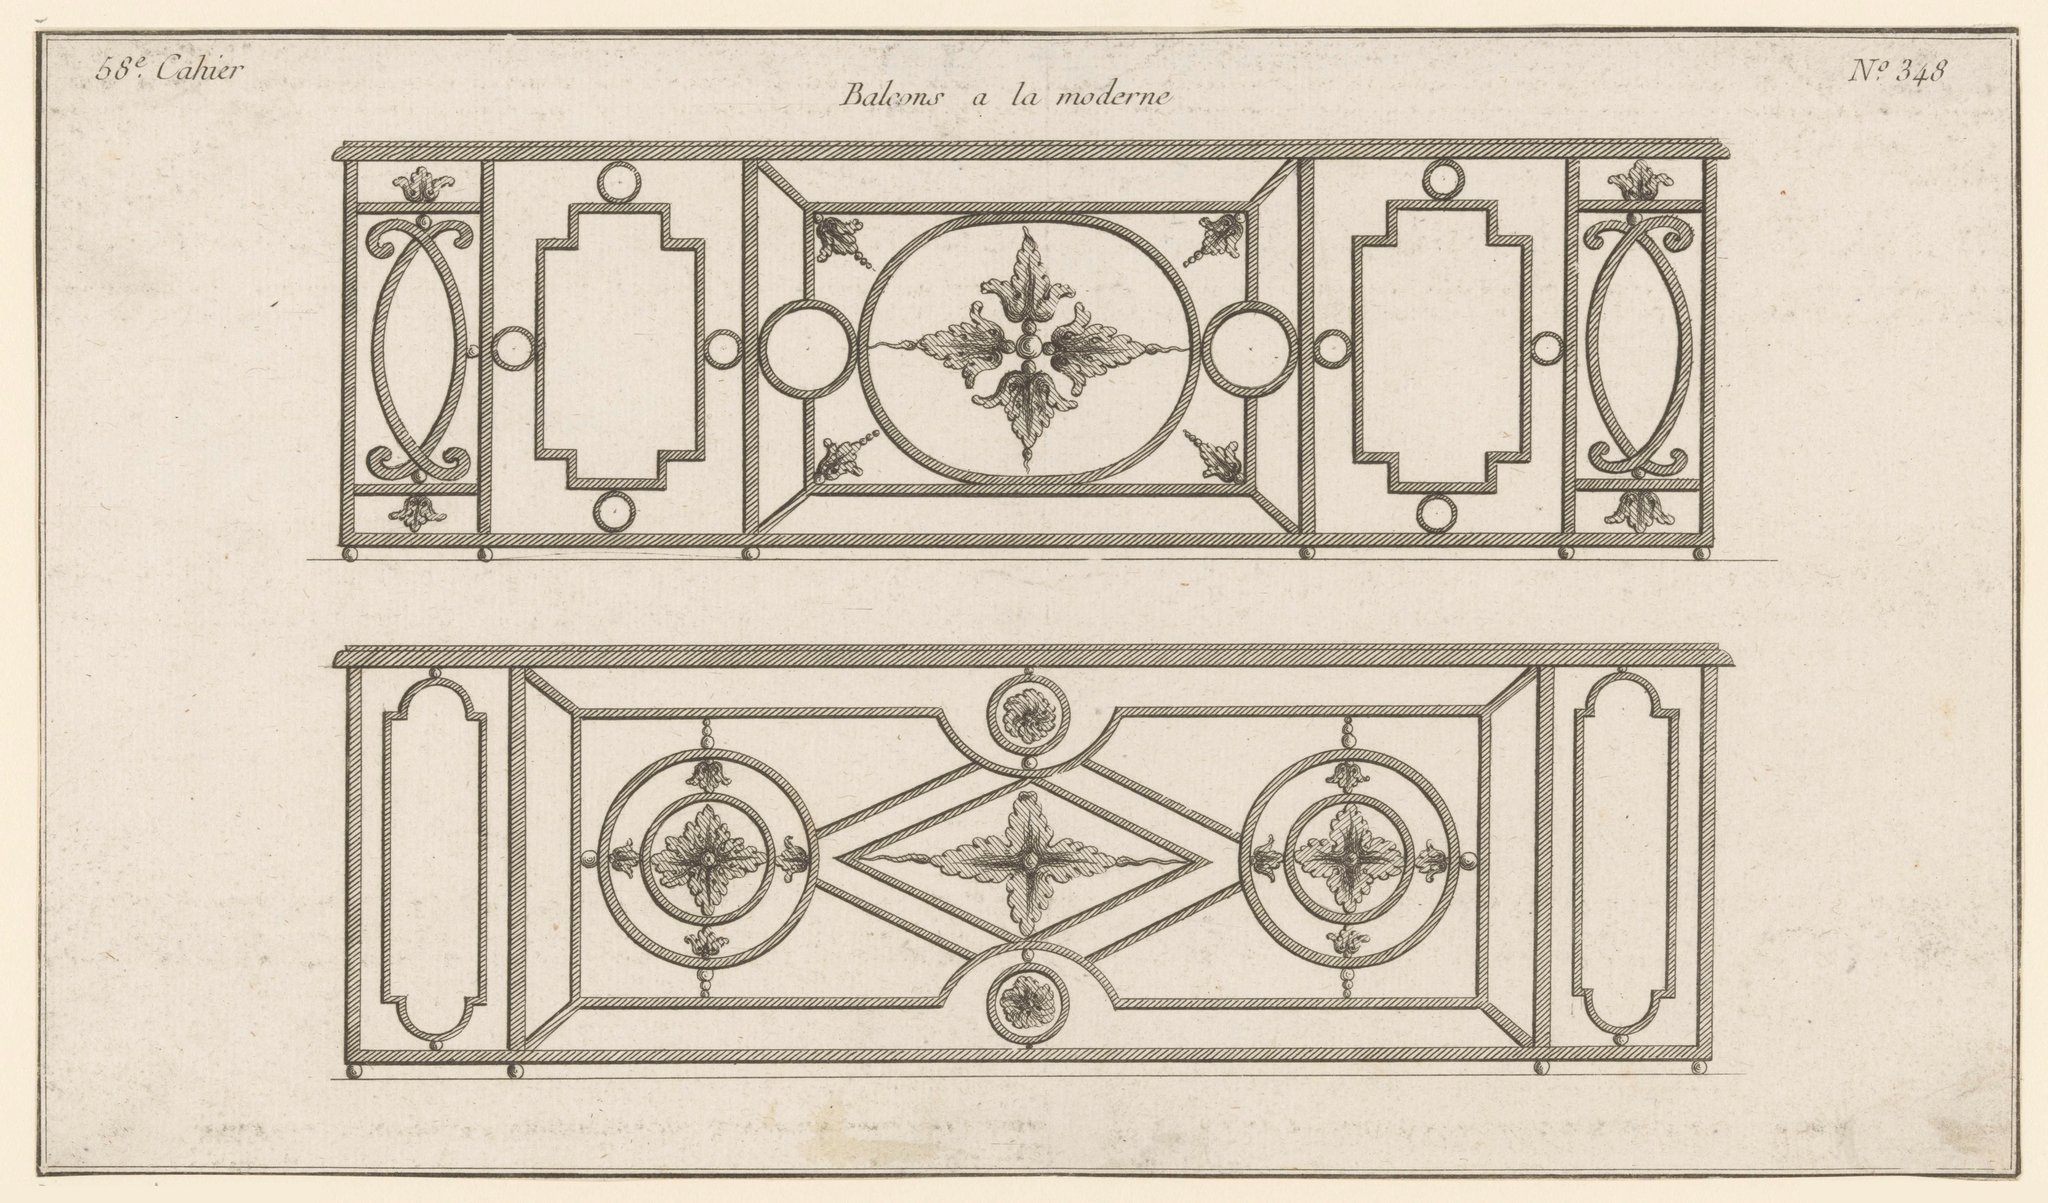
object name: print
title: Balkonhekken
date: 1772-1779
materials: paper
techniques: engraving, etching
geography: paris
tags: balcony, flowers ~ ornament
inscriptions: collector's mark: Lugt 2760, collector's mark: Lugt 2228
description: Twee smeedijzeren balkonhekken met bloemmotieven. Prentnummer 348.